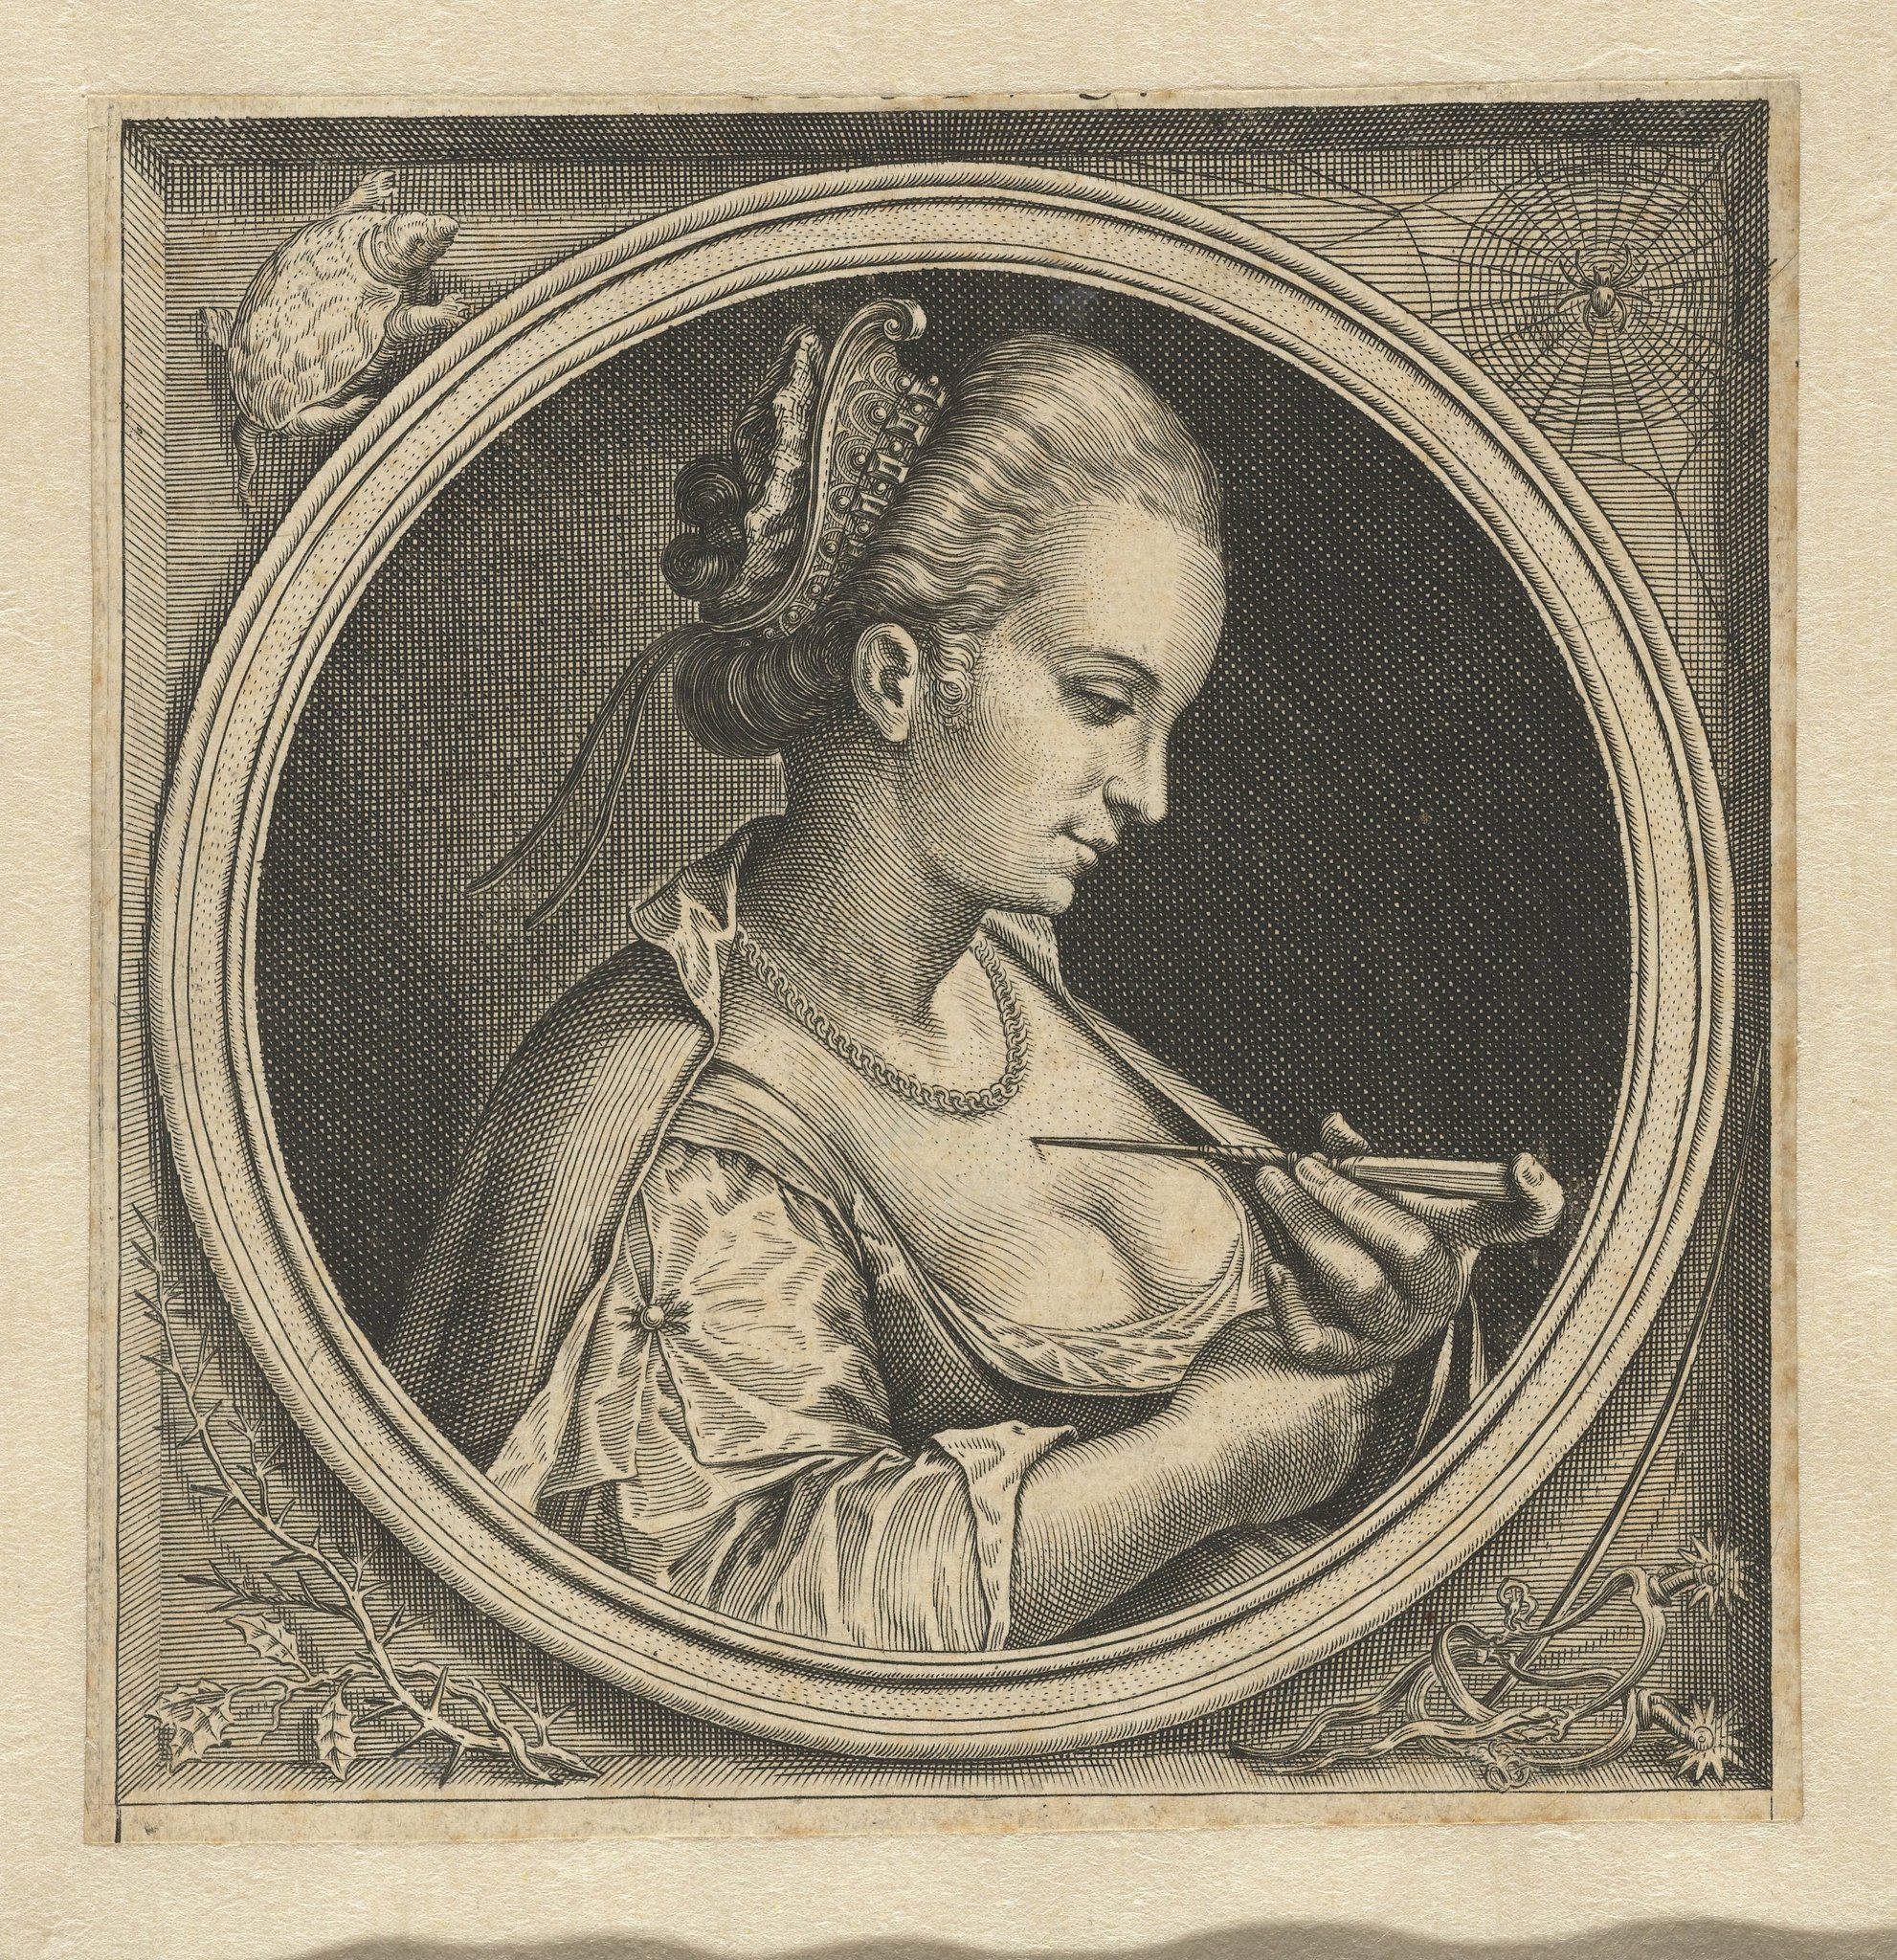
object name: print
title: De vijf zintuigen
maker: jacob van der heyden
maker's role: draughtsman, print maker, publisher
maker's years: 1573-1645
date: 1583-1645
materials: paper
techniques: engraving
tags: plants and herbs: holly, tortoises, turtles, feeling (one of the five senses), spur, spiders, needle ~ sewing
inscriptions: collector's mark: Lugt 2228, collector's mark: Lugt 2166